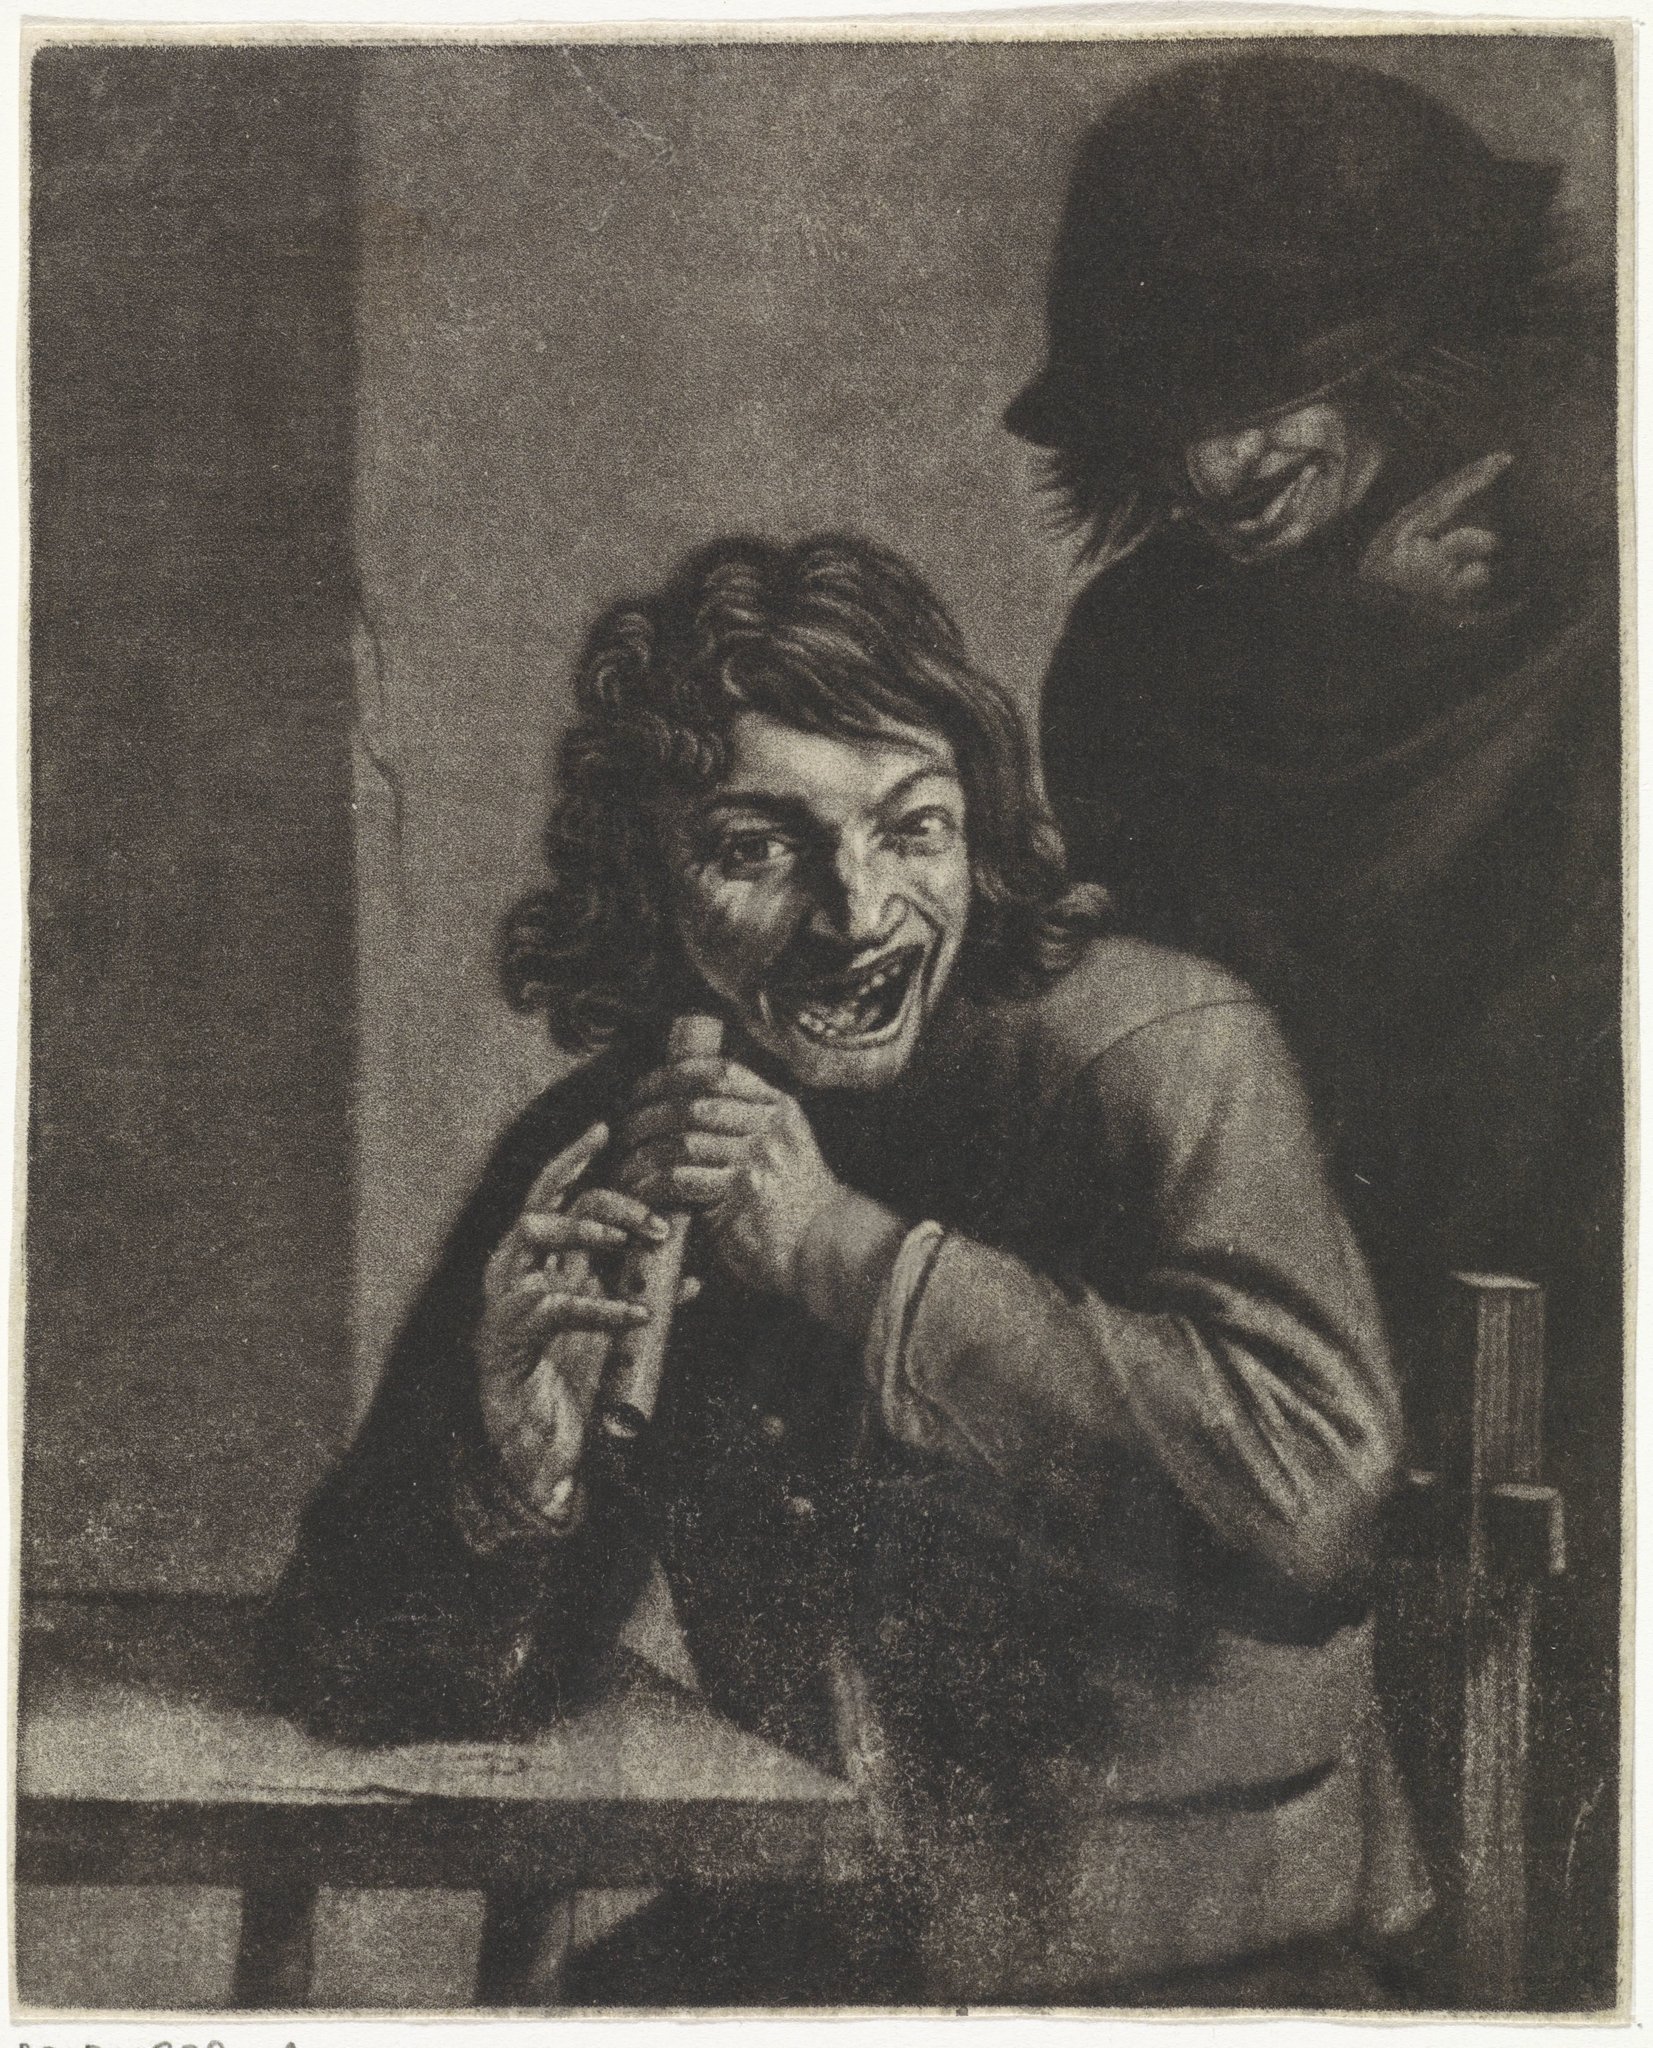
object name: print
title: Jongen met fluit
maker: jan van der bruggen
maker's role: draughtsman, print maker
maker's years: 1649-1709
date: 1659-1740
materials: paper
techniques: mezzotint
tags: one person playing wind instrument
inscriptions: collector's mark: Lugt 2228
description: Een jongen met in zijn handen een fluit zit aan een tafel. Achter hem staat een man met een hoed op het hoofd in zijn mantel gewikkeld.